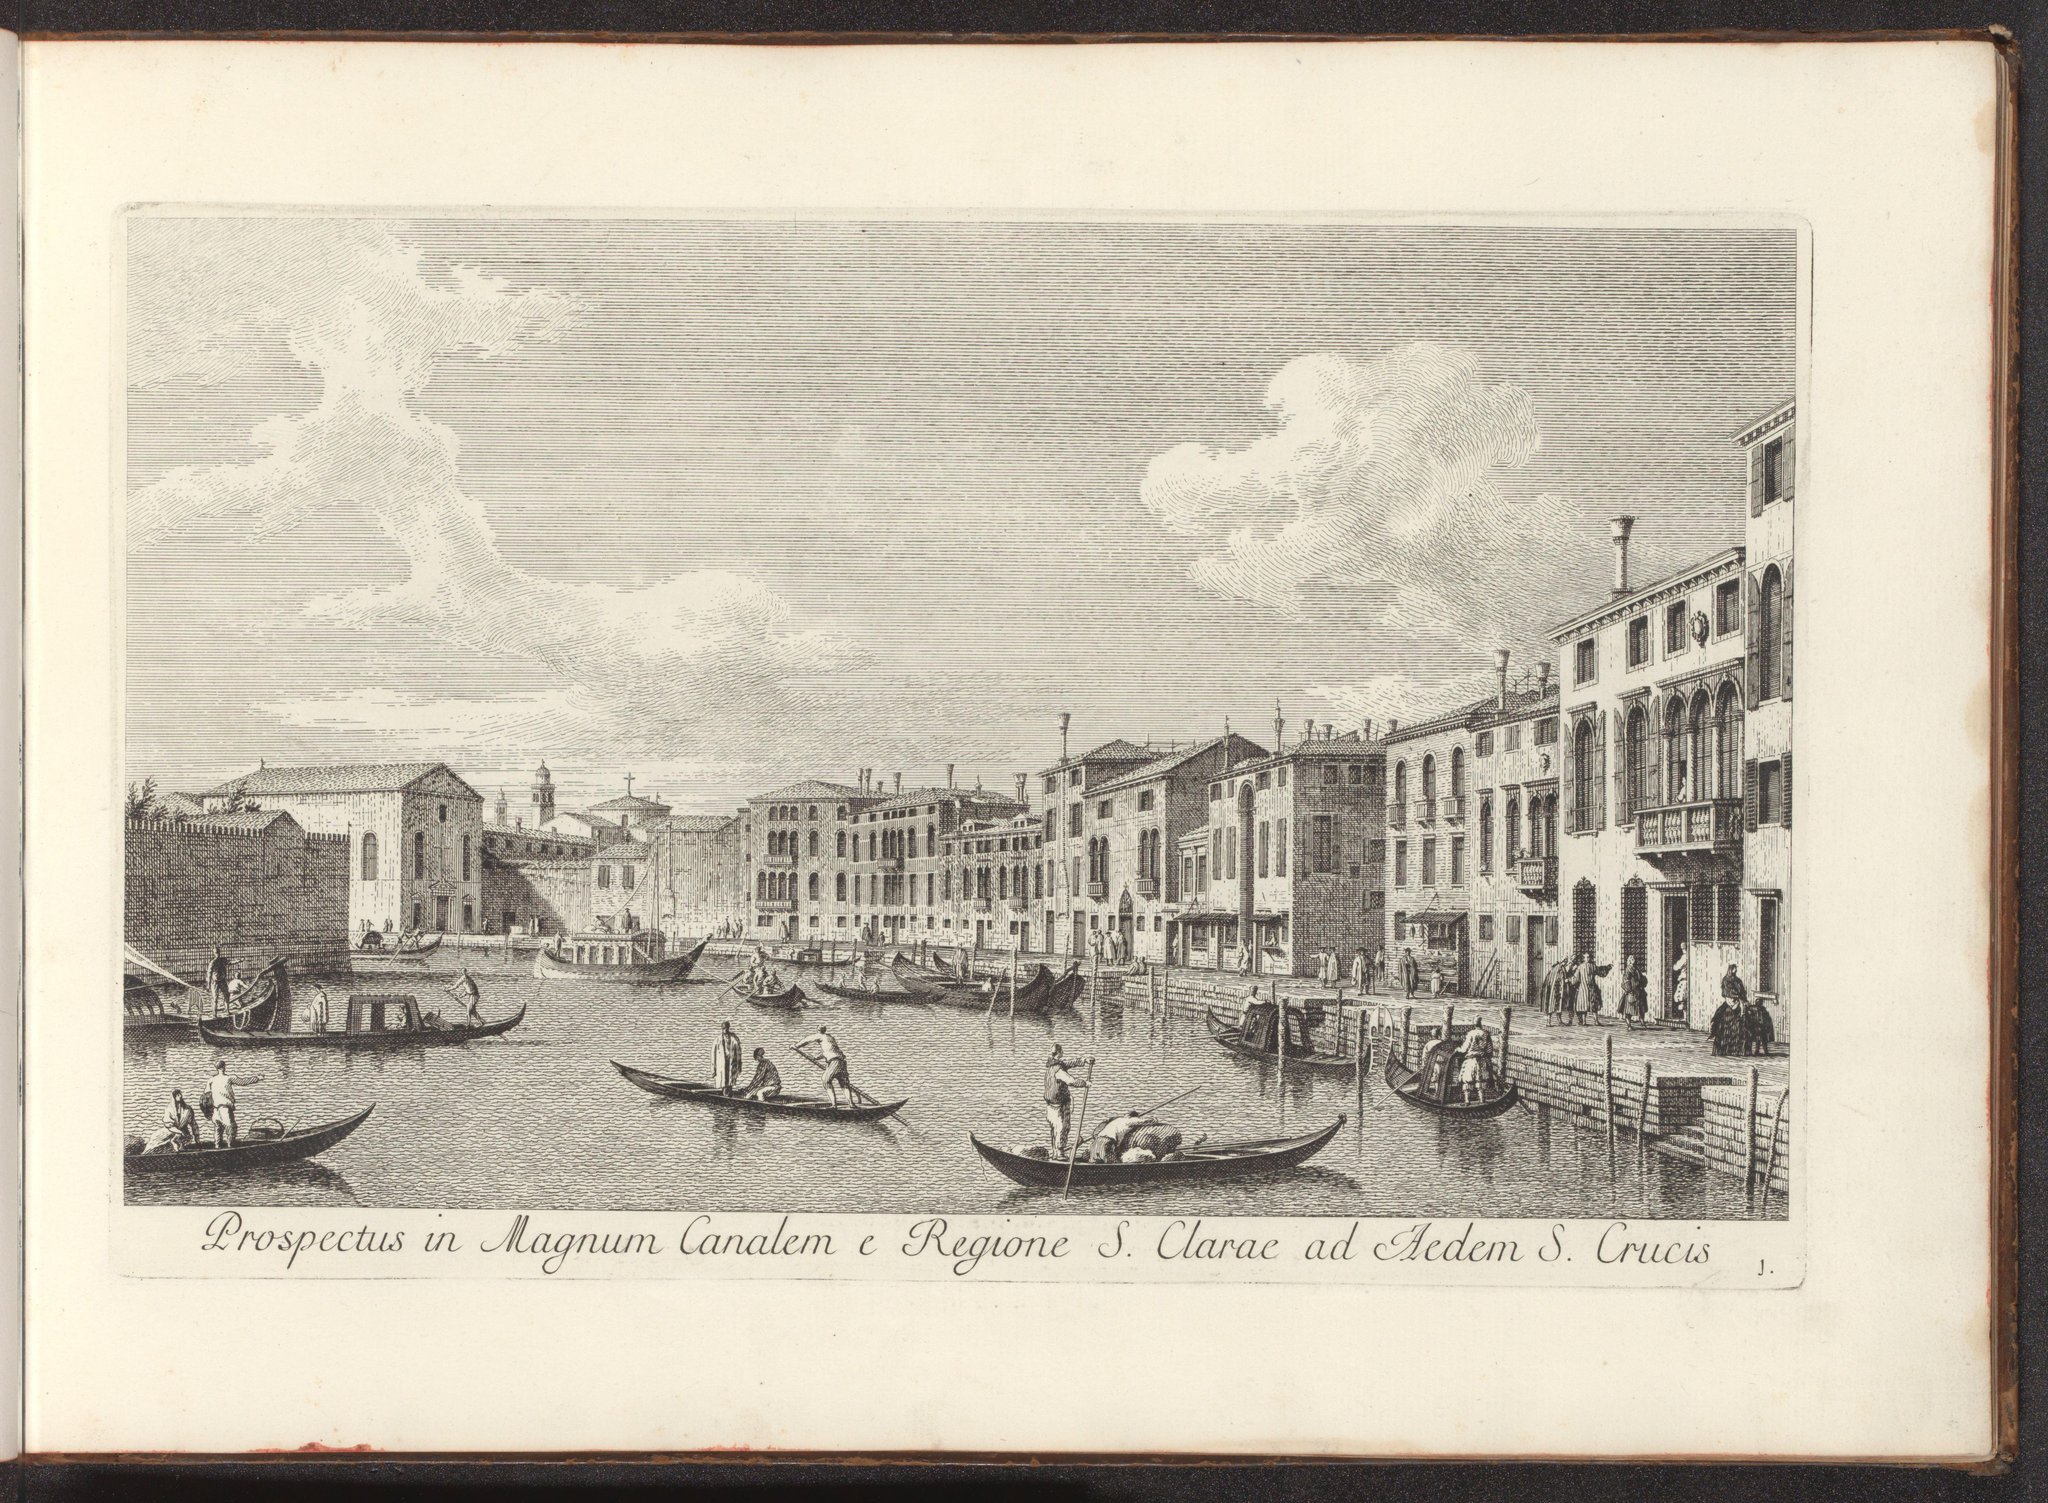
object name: album leaf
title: Prospectus Magni Canalis Venetiarum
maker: antonio visentini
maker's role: draughtsman, print maker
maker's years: 1688-1782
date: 1742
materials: paper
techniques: etching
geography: venice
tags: city-view, and landscape with man-made constructions, canal